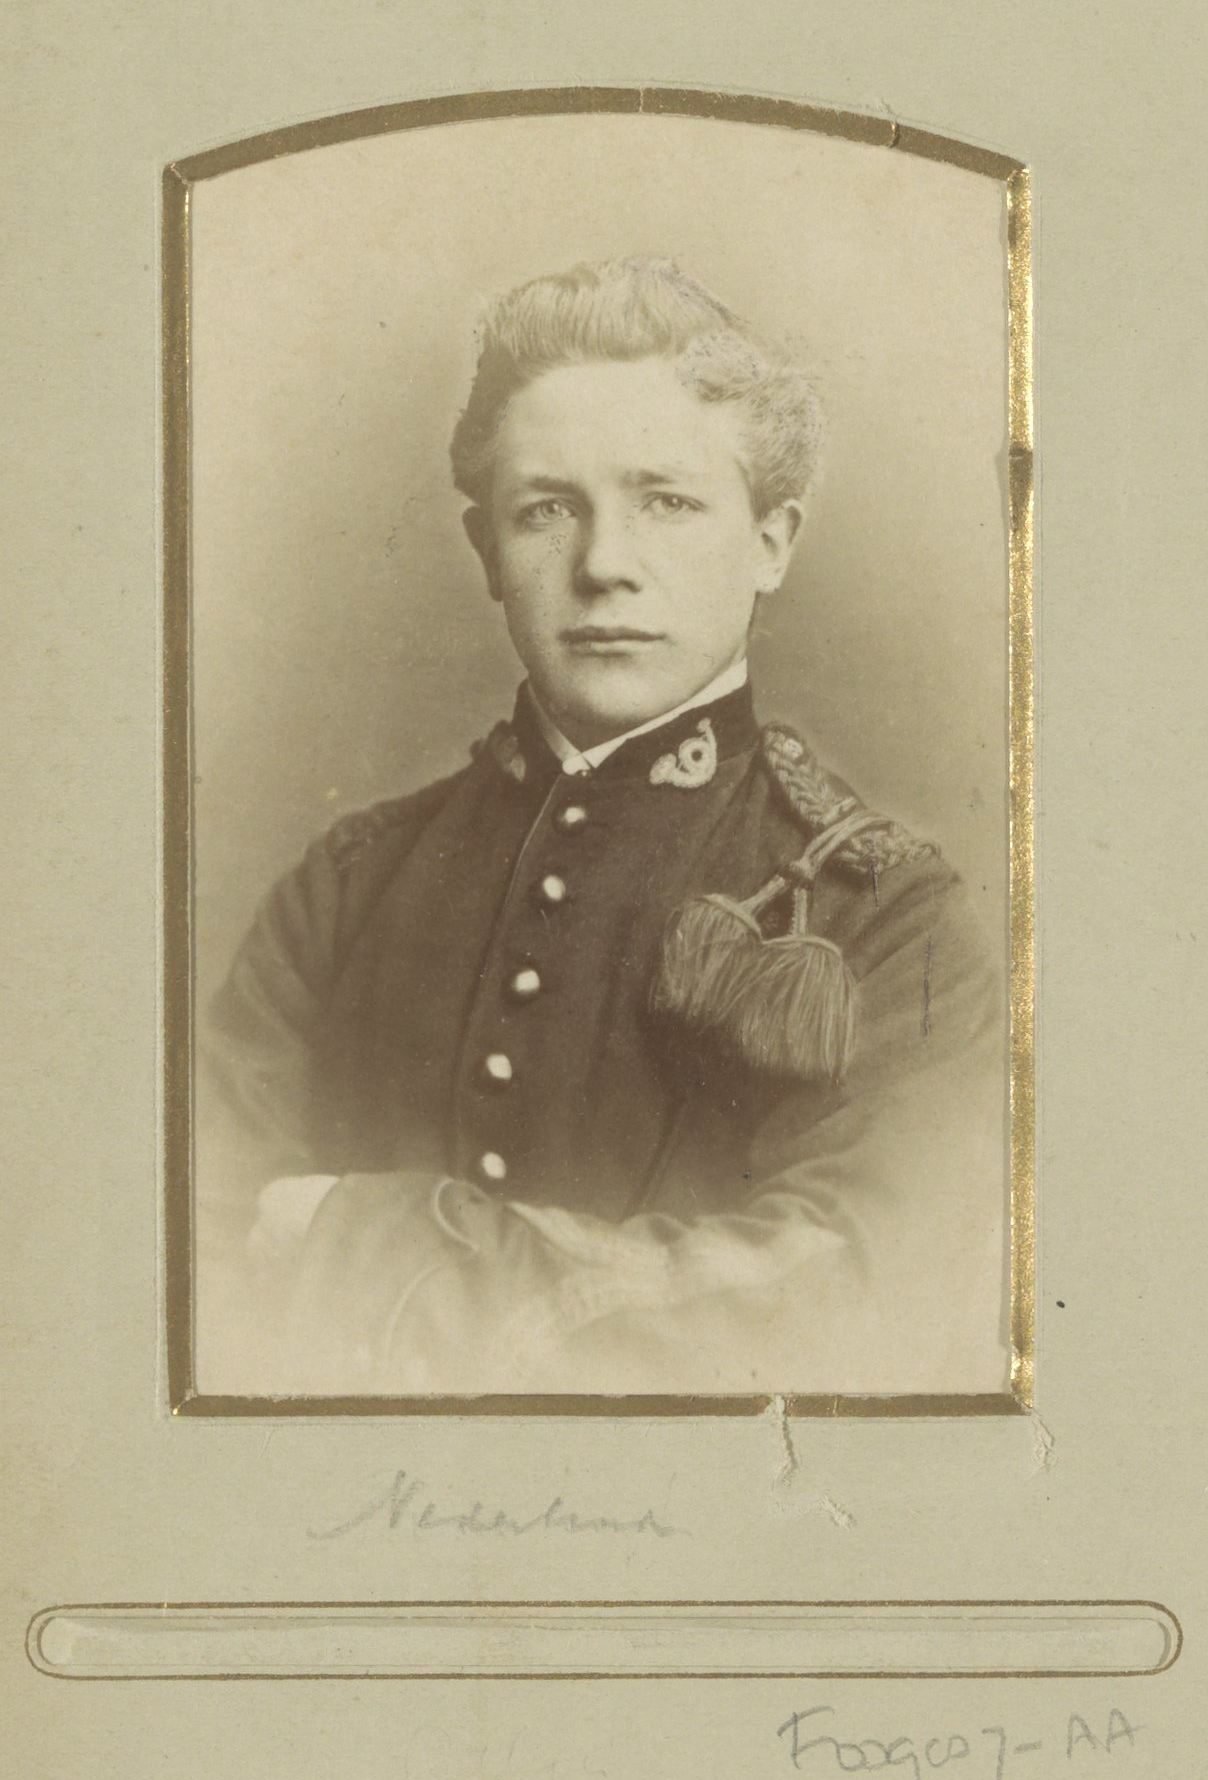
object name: album leaf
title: Portret van een (vermoedelijk) Nederlandse militair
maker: bernardus bruining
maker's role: fotograaf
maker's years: 1834-1900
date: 1860-1880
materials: cardboard, paper, photographic support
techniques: albumen print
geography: leiden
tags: warfare; military affairs, (military) uniforms, division of armed forces, leiden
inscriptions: address: ‘Leiden’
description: Onderdeel van Album met cartes-de-visite en kabinetfoto's van militairen in uniform.